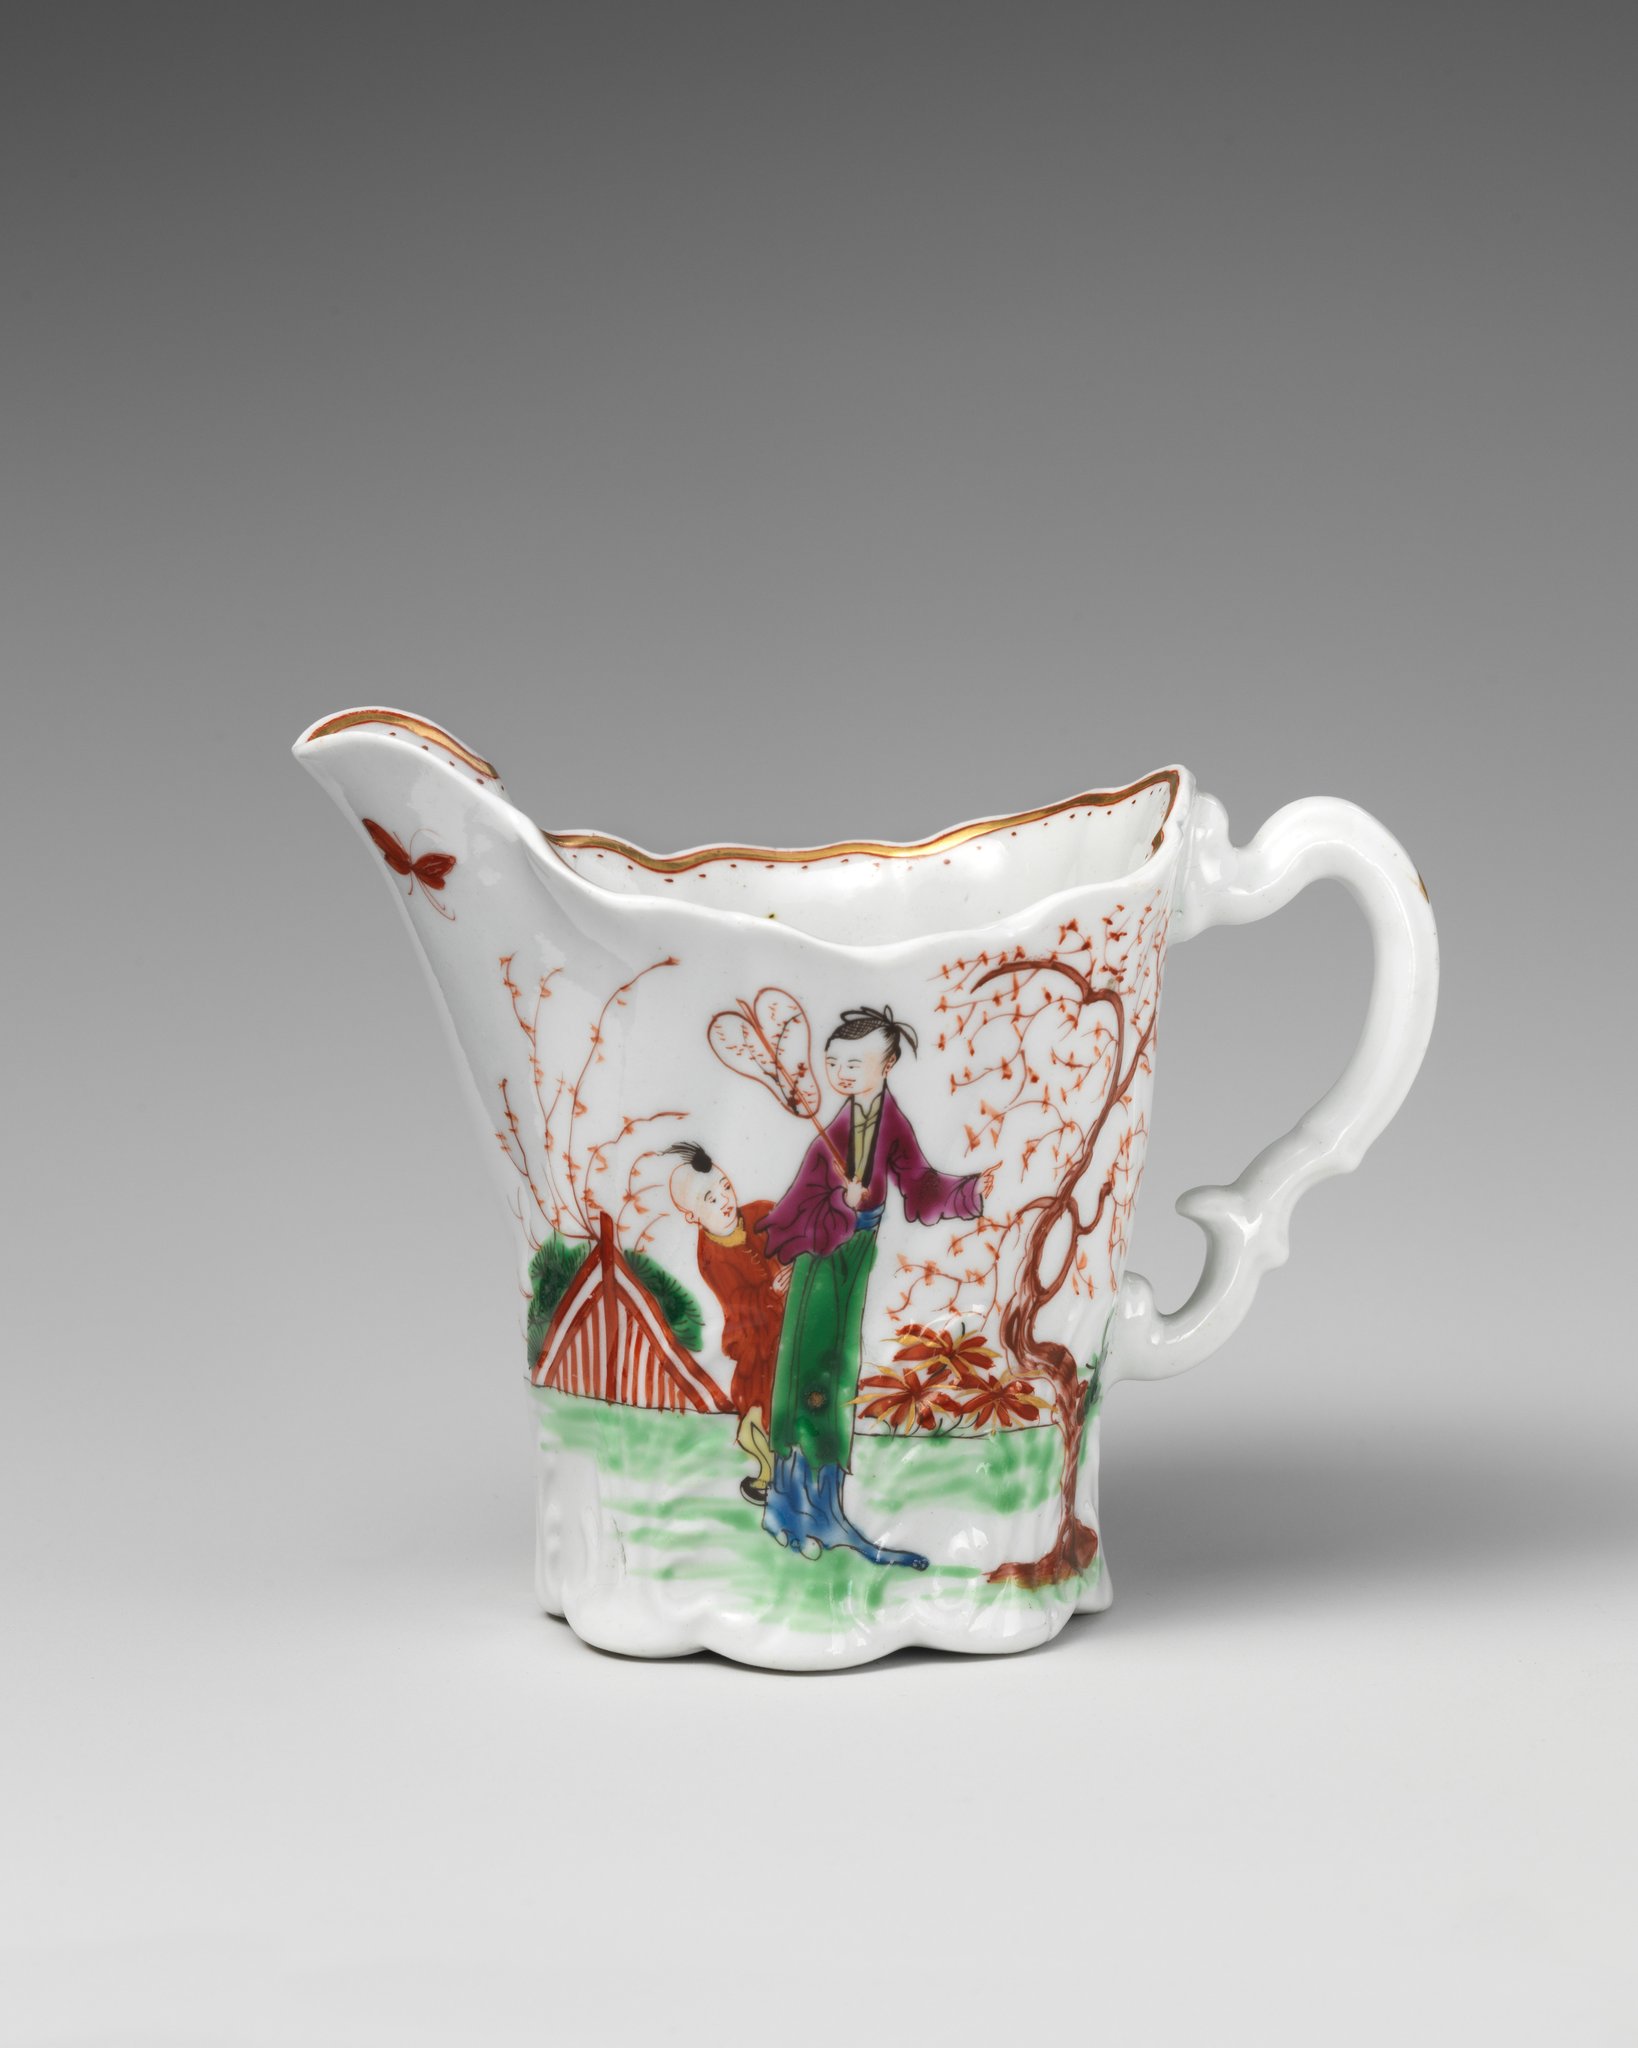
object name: jug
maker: worcester factory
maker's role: factory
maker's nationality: british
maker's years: 1751-2008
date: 1753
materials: soft paste porcelain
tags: chinoiserie,children